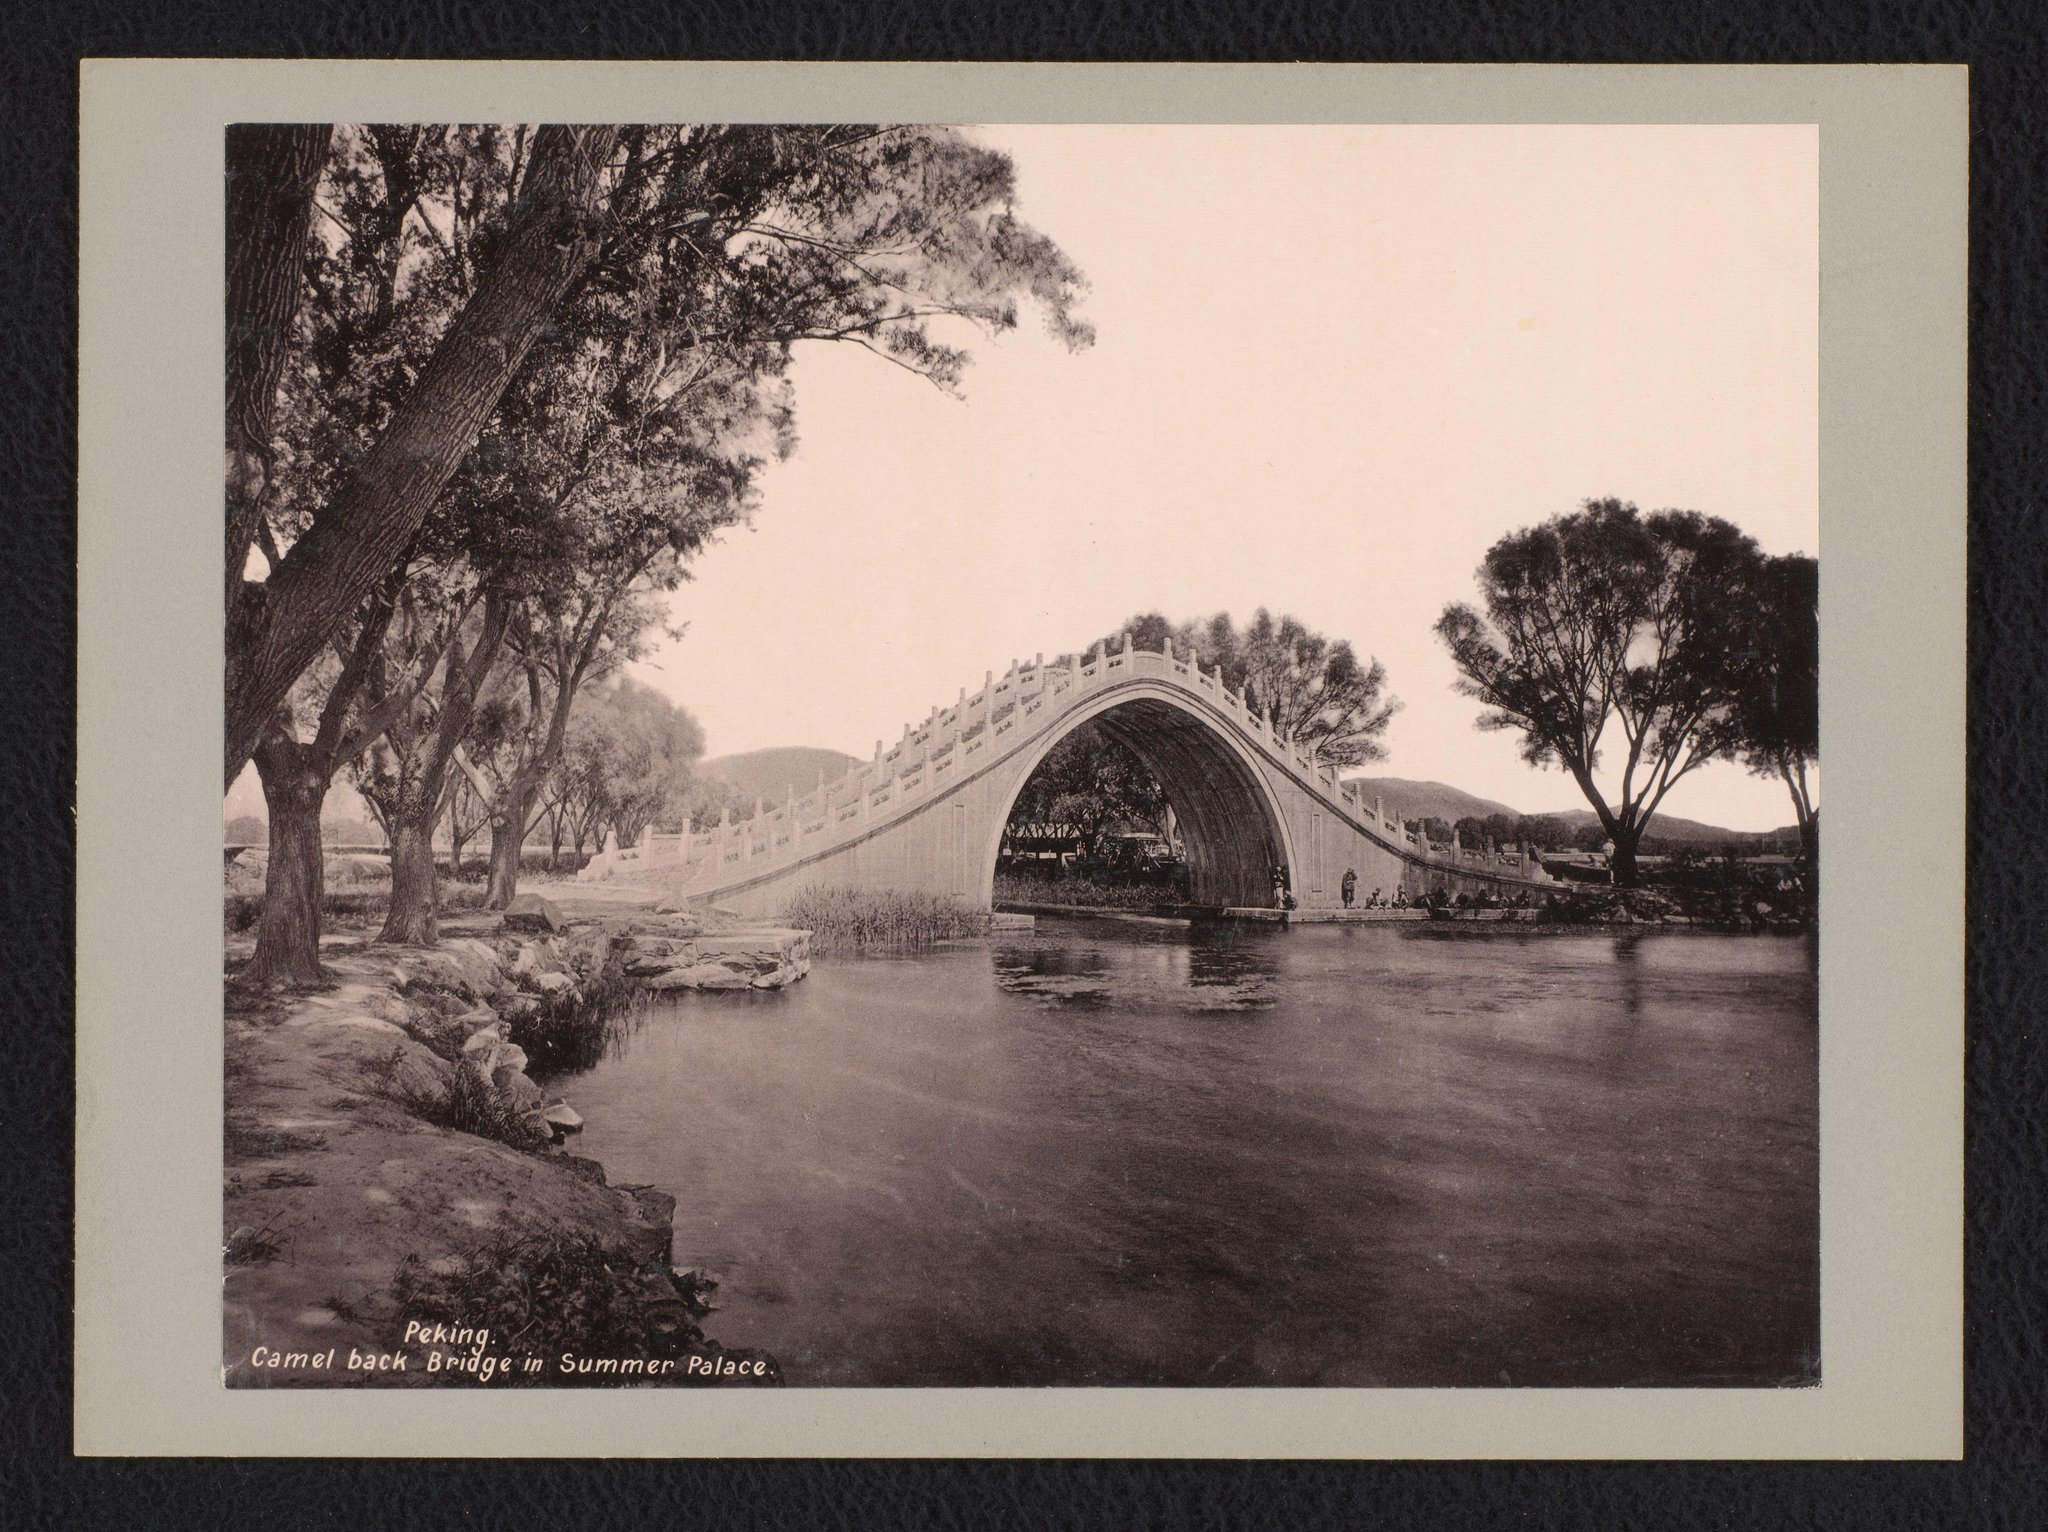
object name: photograph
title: Boogbrug in Zomerpaleis, Peking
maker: Anonymous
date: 1895-1915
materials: cardboard, photographic support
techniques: photograph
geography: beijing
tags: peking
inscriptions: number: ‘10.’